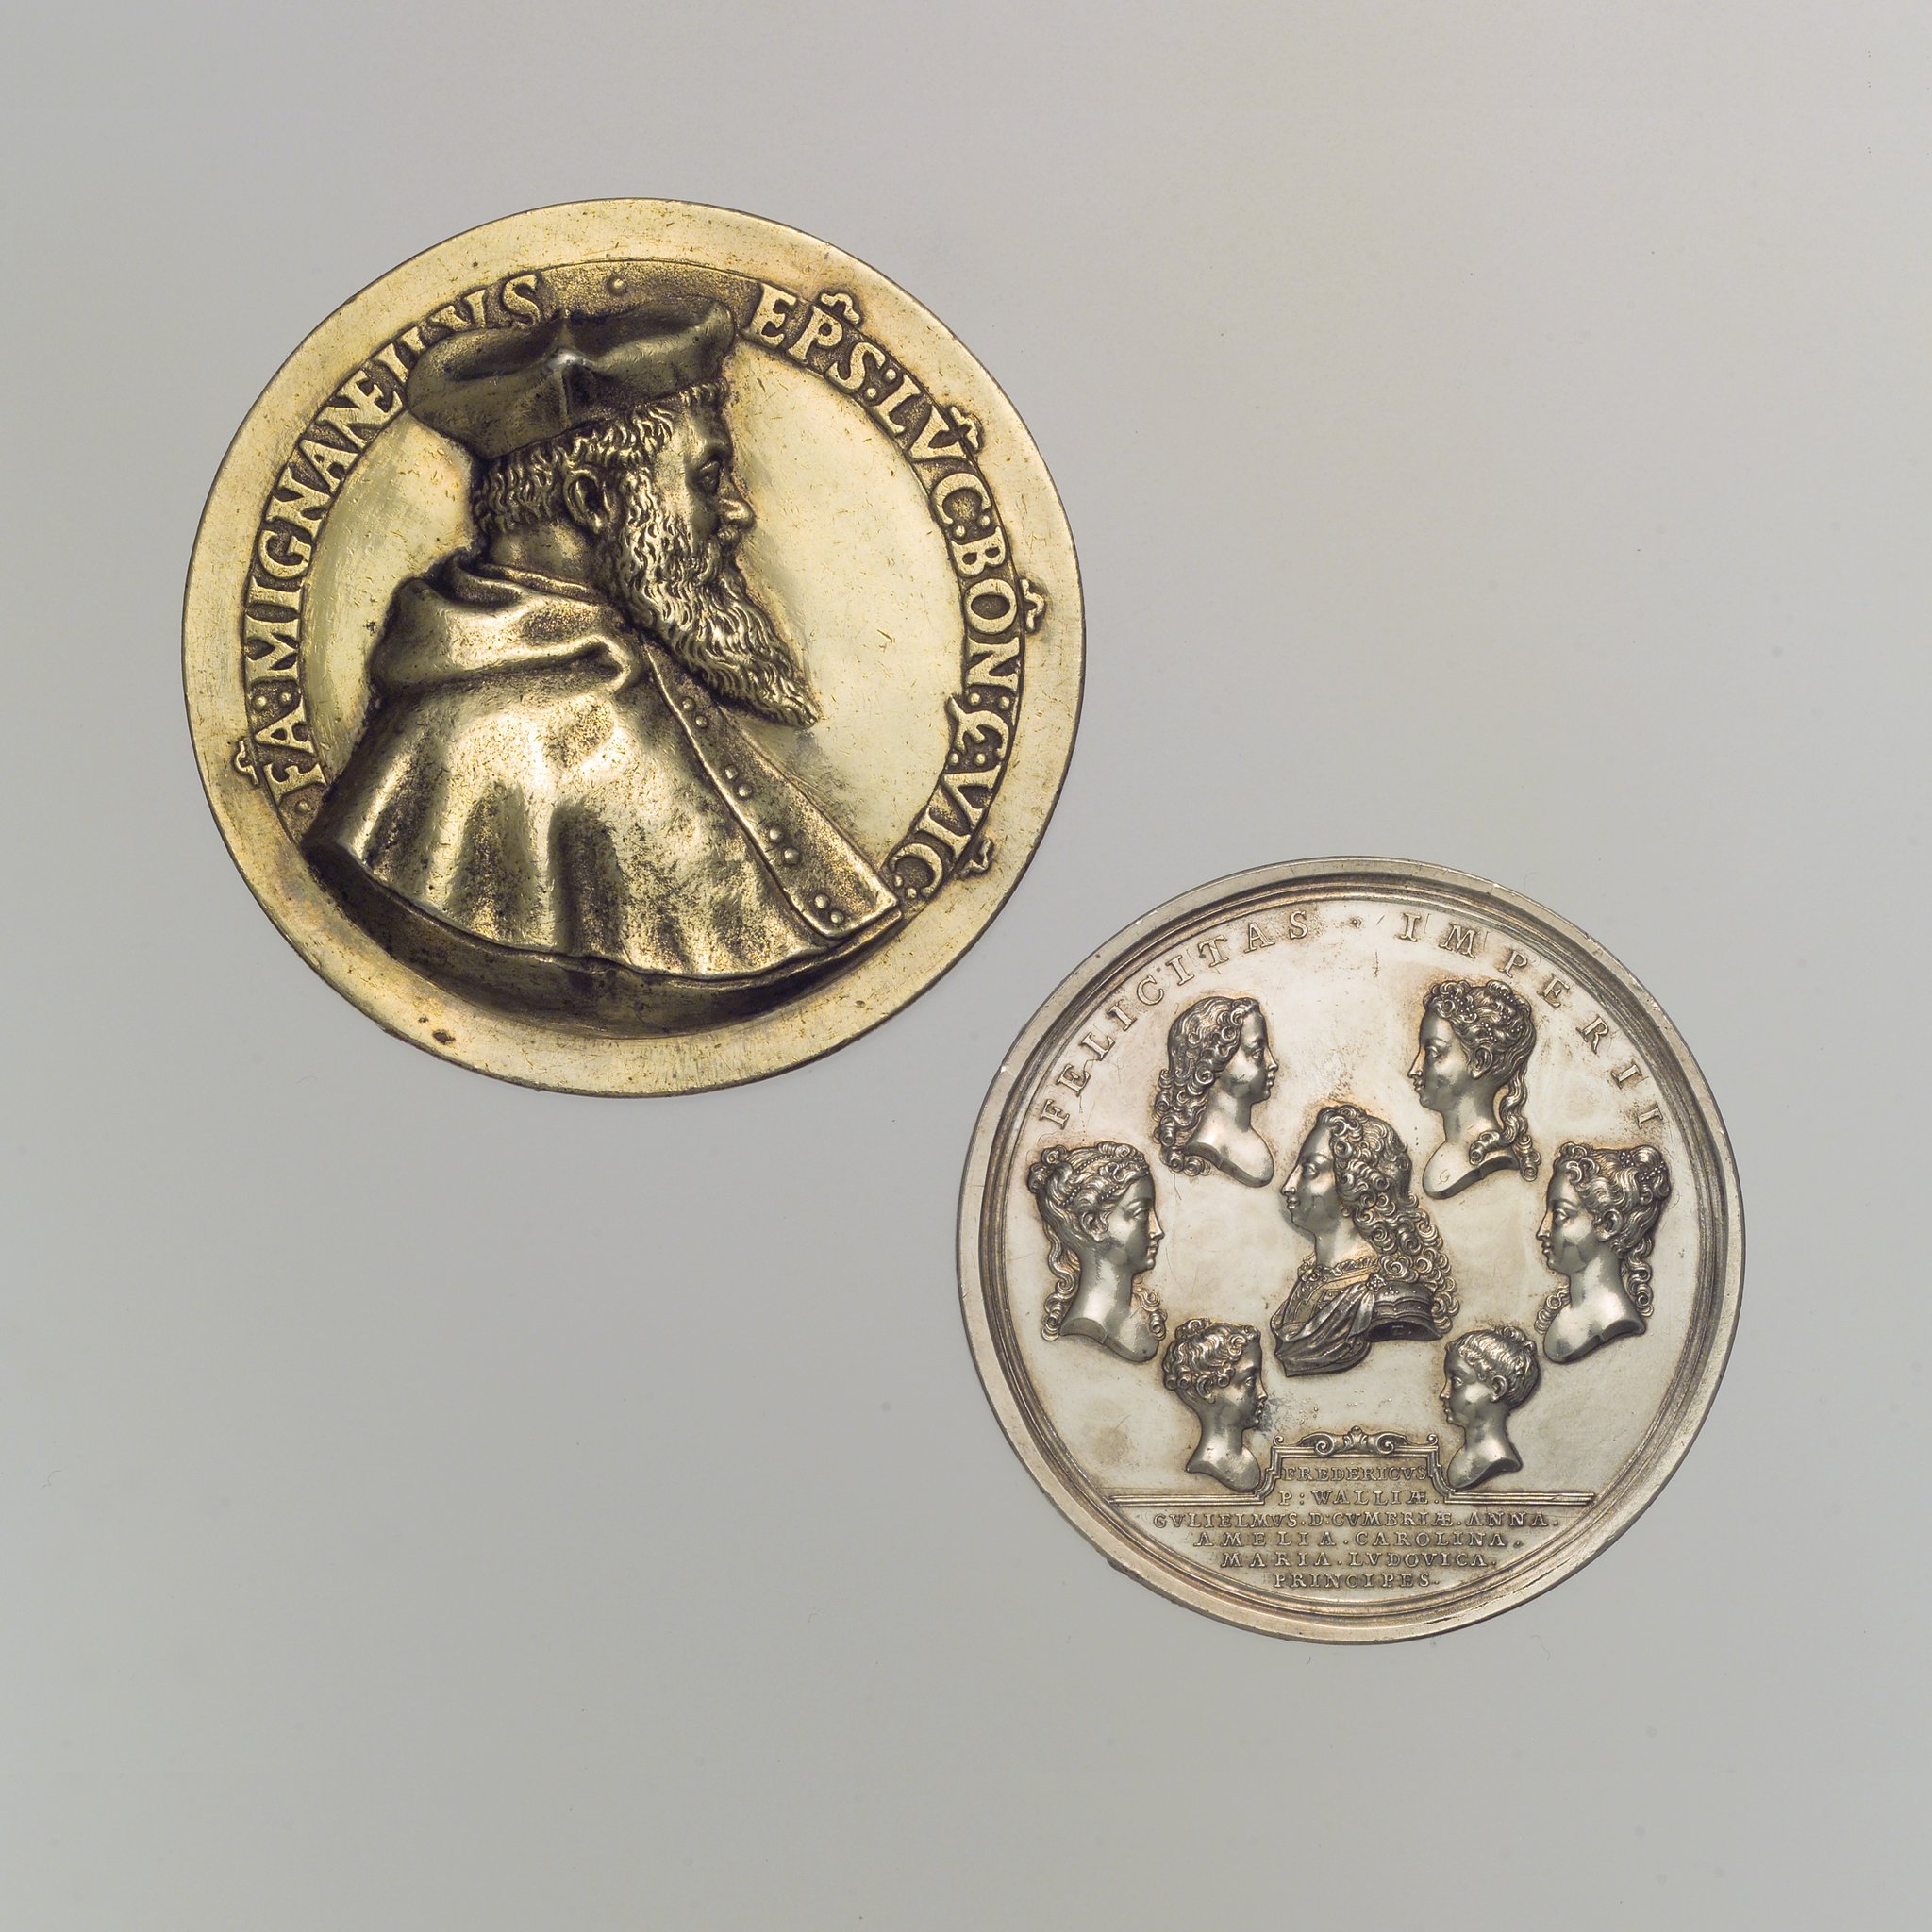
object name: medal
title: Cardinal Fabio Mignanelli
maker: giovanni zacchi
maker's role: maker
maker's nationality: italian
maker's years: 1512-1565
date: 1551-1557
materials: silver gilt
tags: men,profiles,women